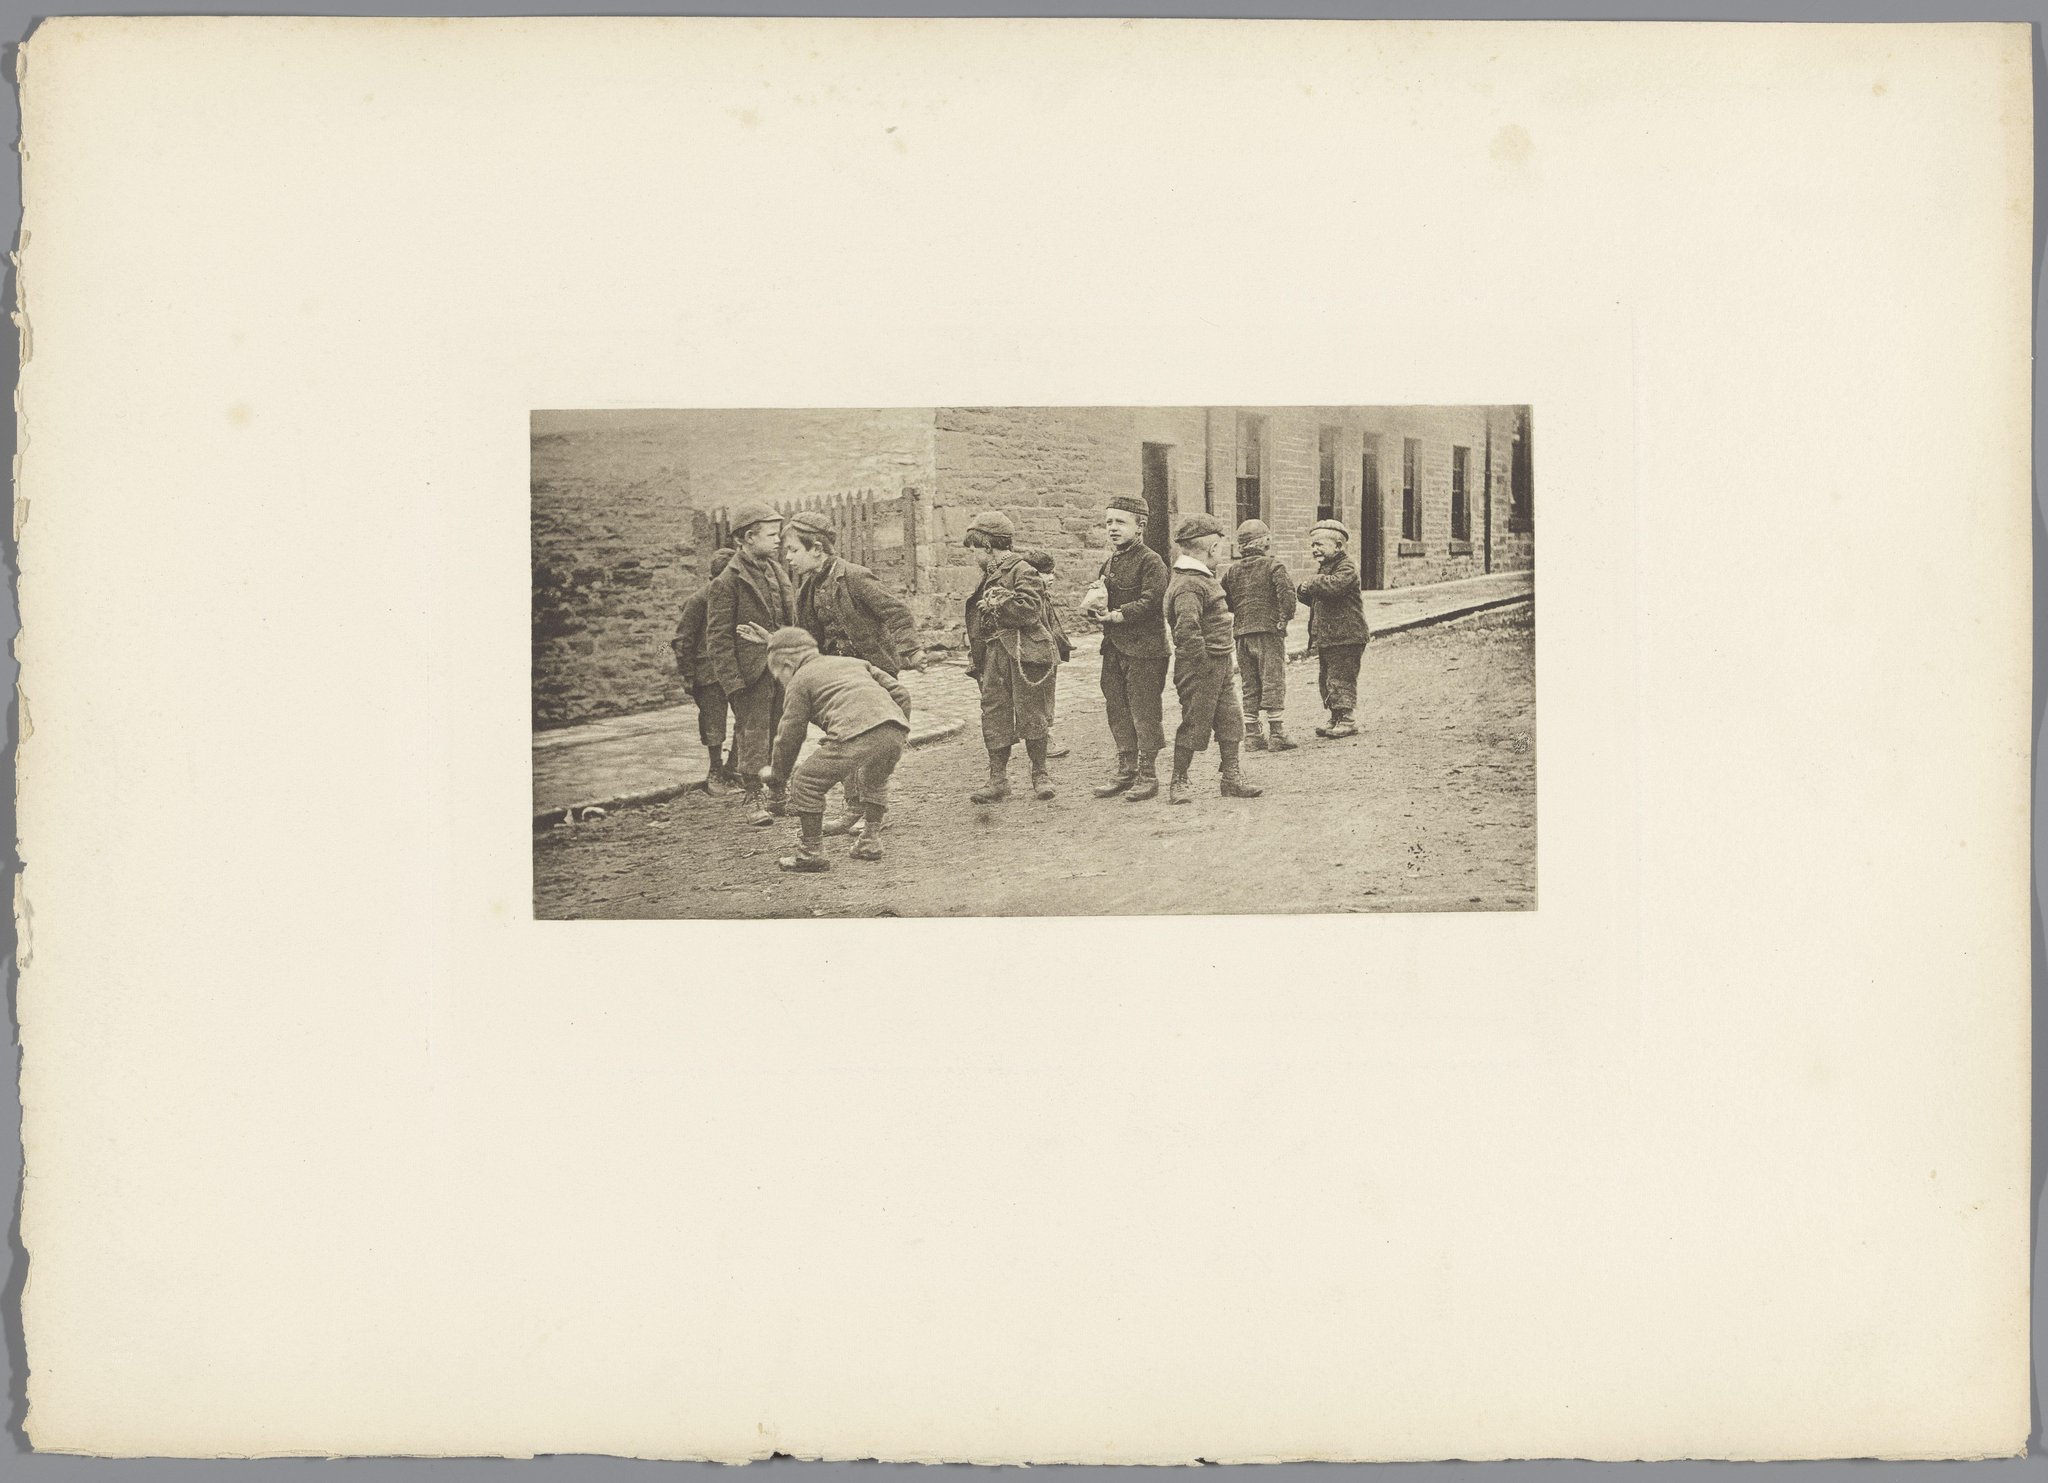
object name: photomechanical print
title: Les uns perdent, les autres gagnent!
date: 1891-1896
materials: paper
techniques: photoaquatint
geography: paris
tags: games without play material, boy (child between toddler and youth), street